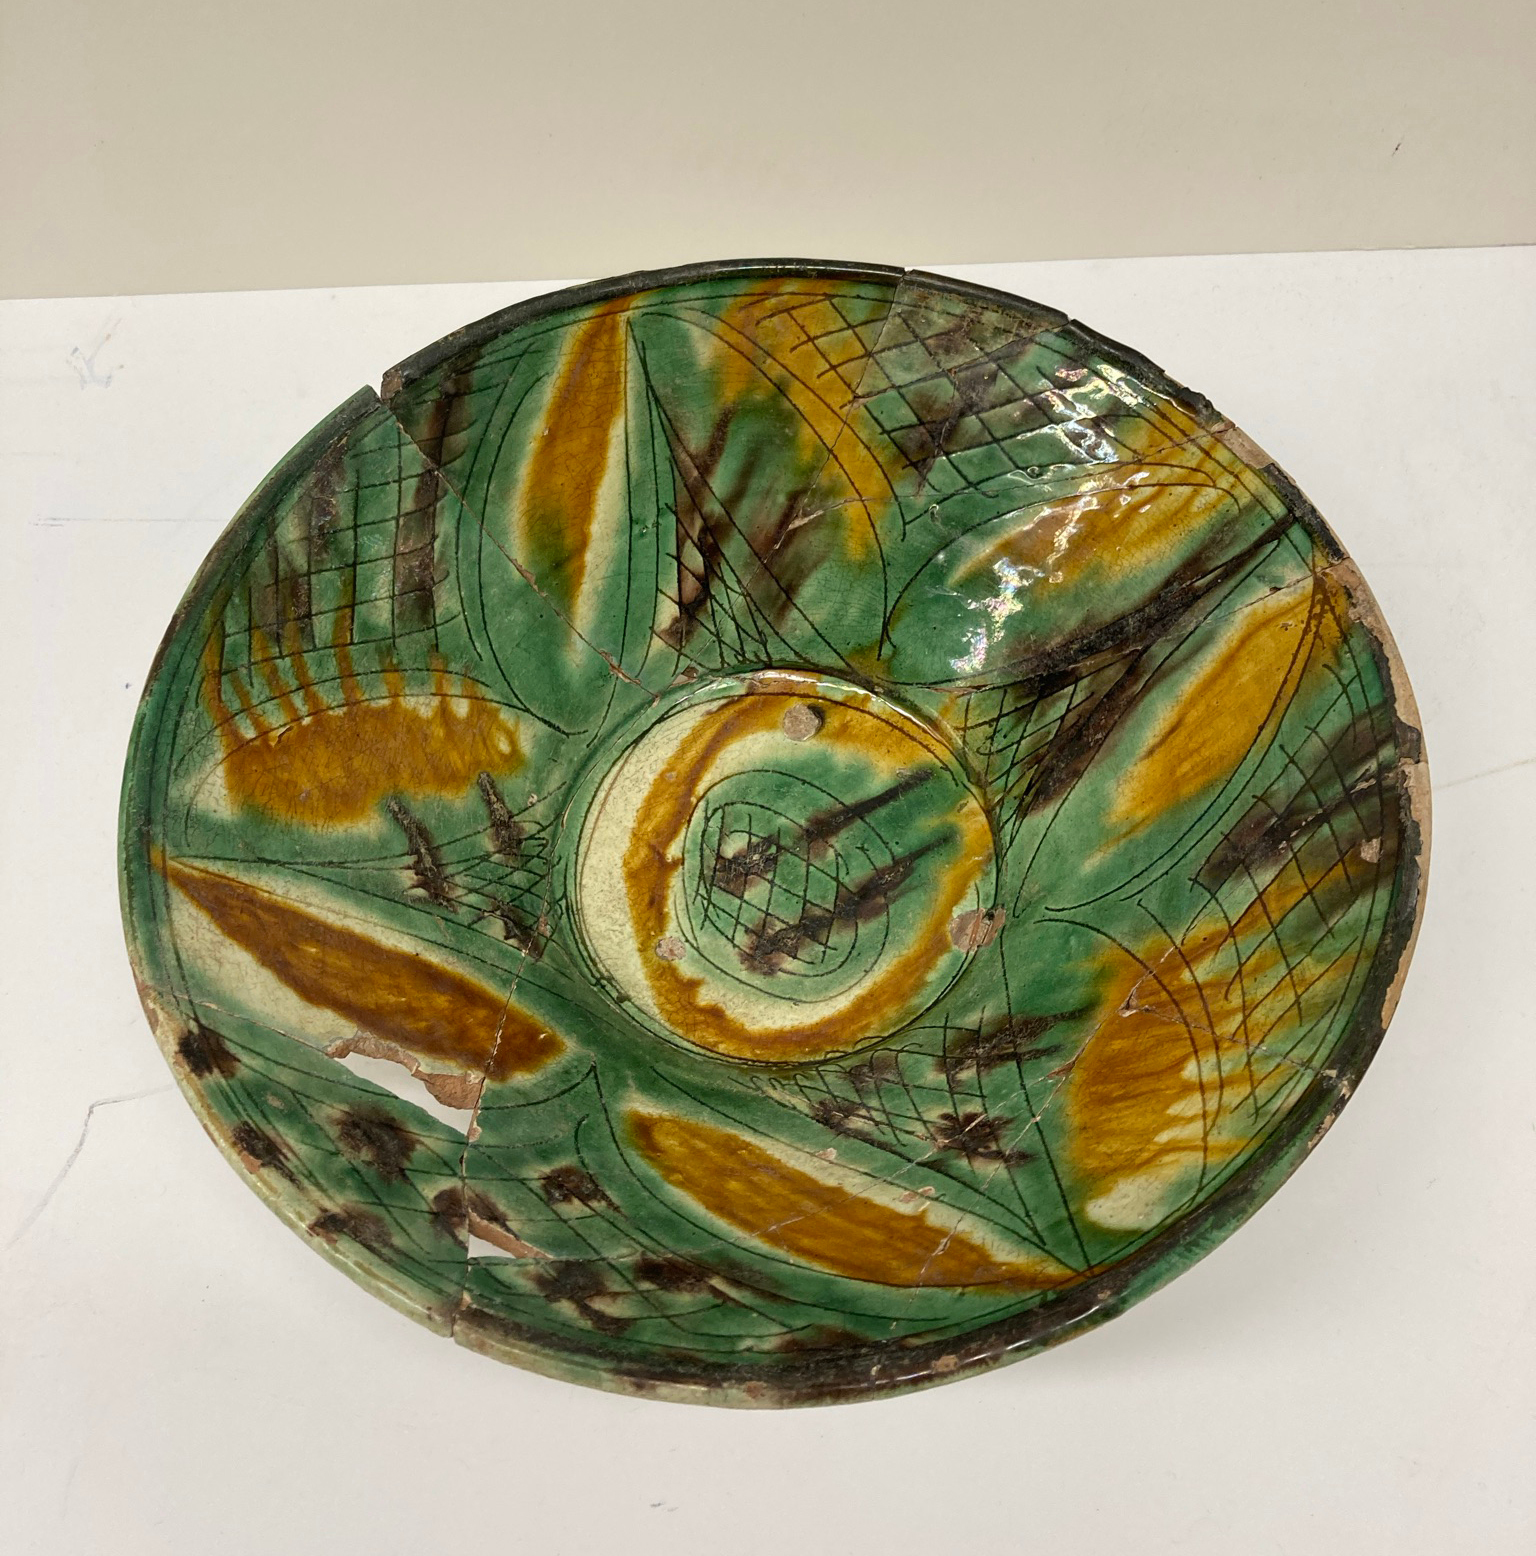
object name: bowl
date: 801-1000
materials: earthenware, glaze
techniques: incising, polychrome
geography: iran